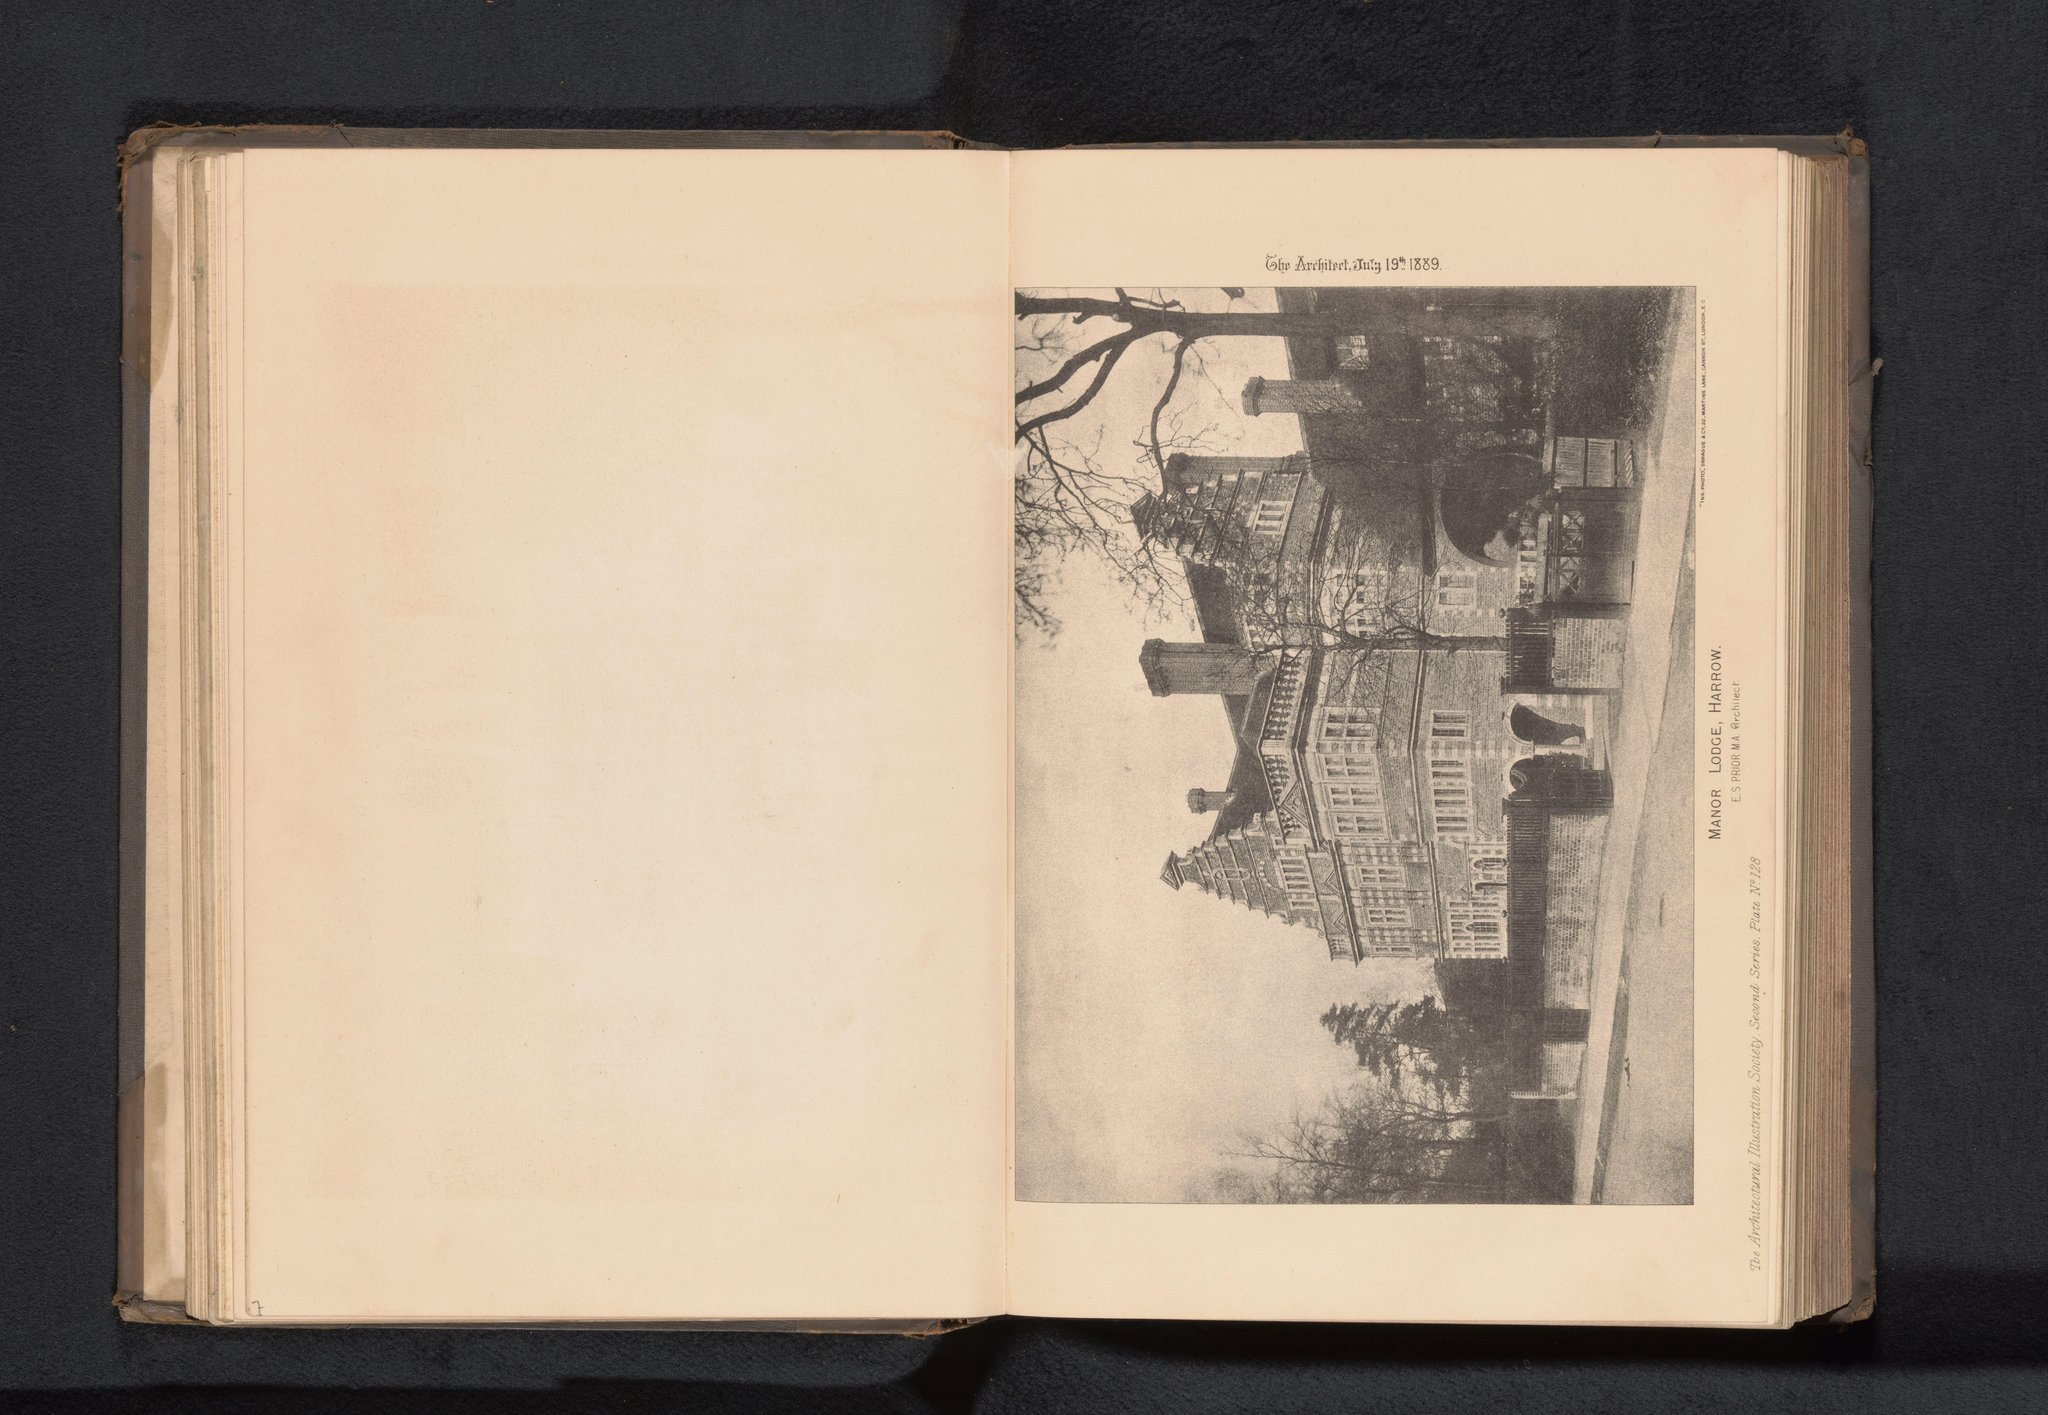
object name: photomechanical print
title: Gezicht op een villa te Harrow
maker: Anonymous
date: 1884-1889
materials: paper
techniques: photolithography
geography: harrow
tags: villa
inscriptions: inscription: ‘E.S. Prior M.A. Architect/ The Architectural Illustration Society. Second Series Plate No.128’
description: Prent op achtste ongenummerde pagina na pagina 34.